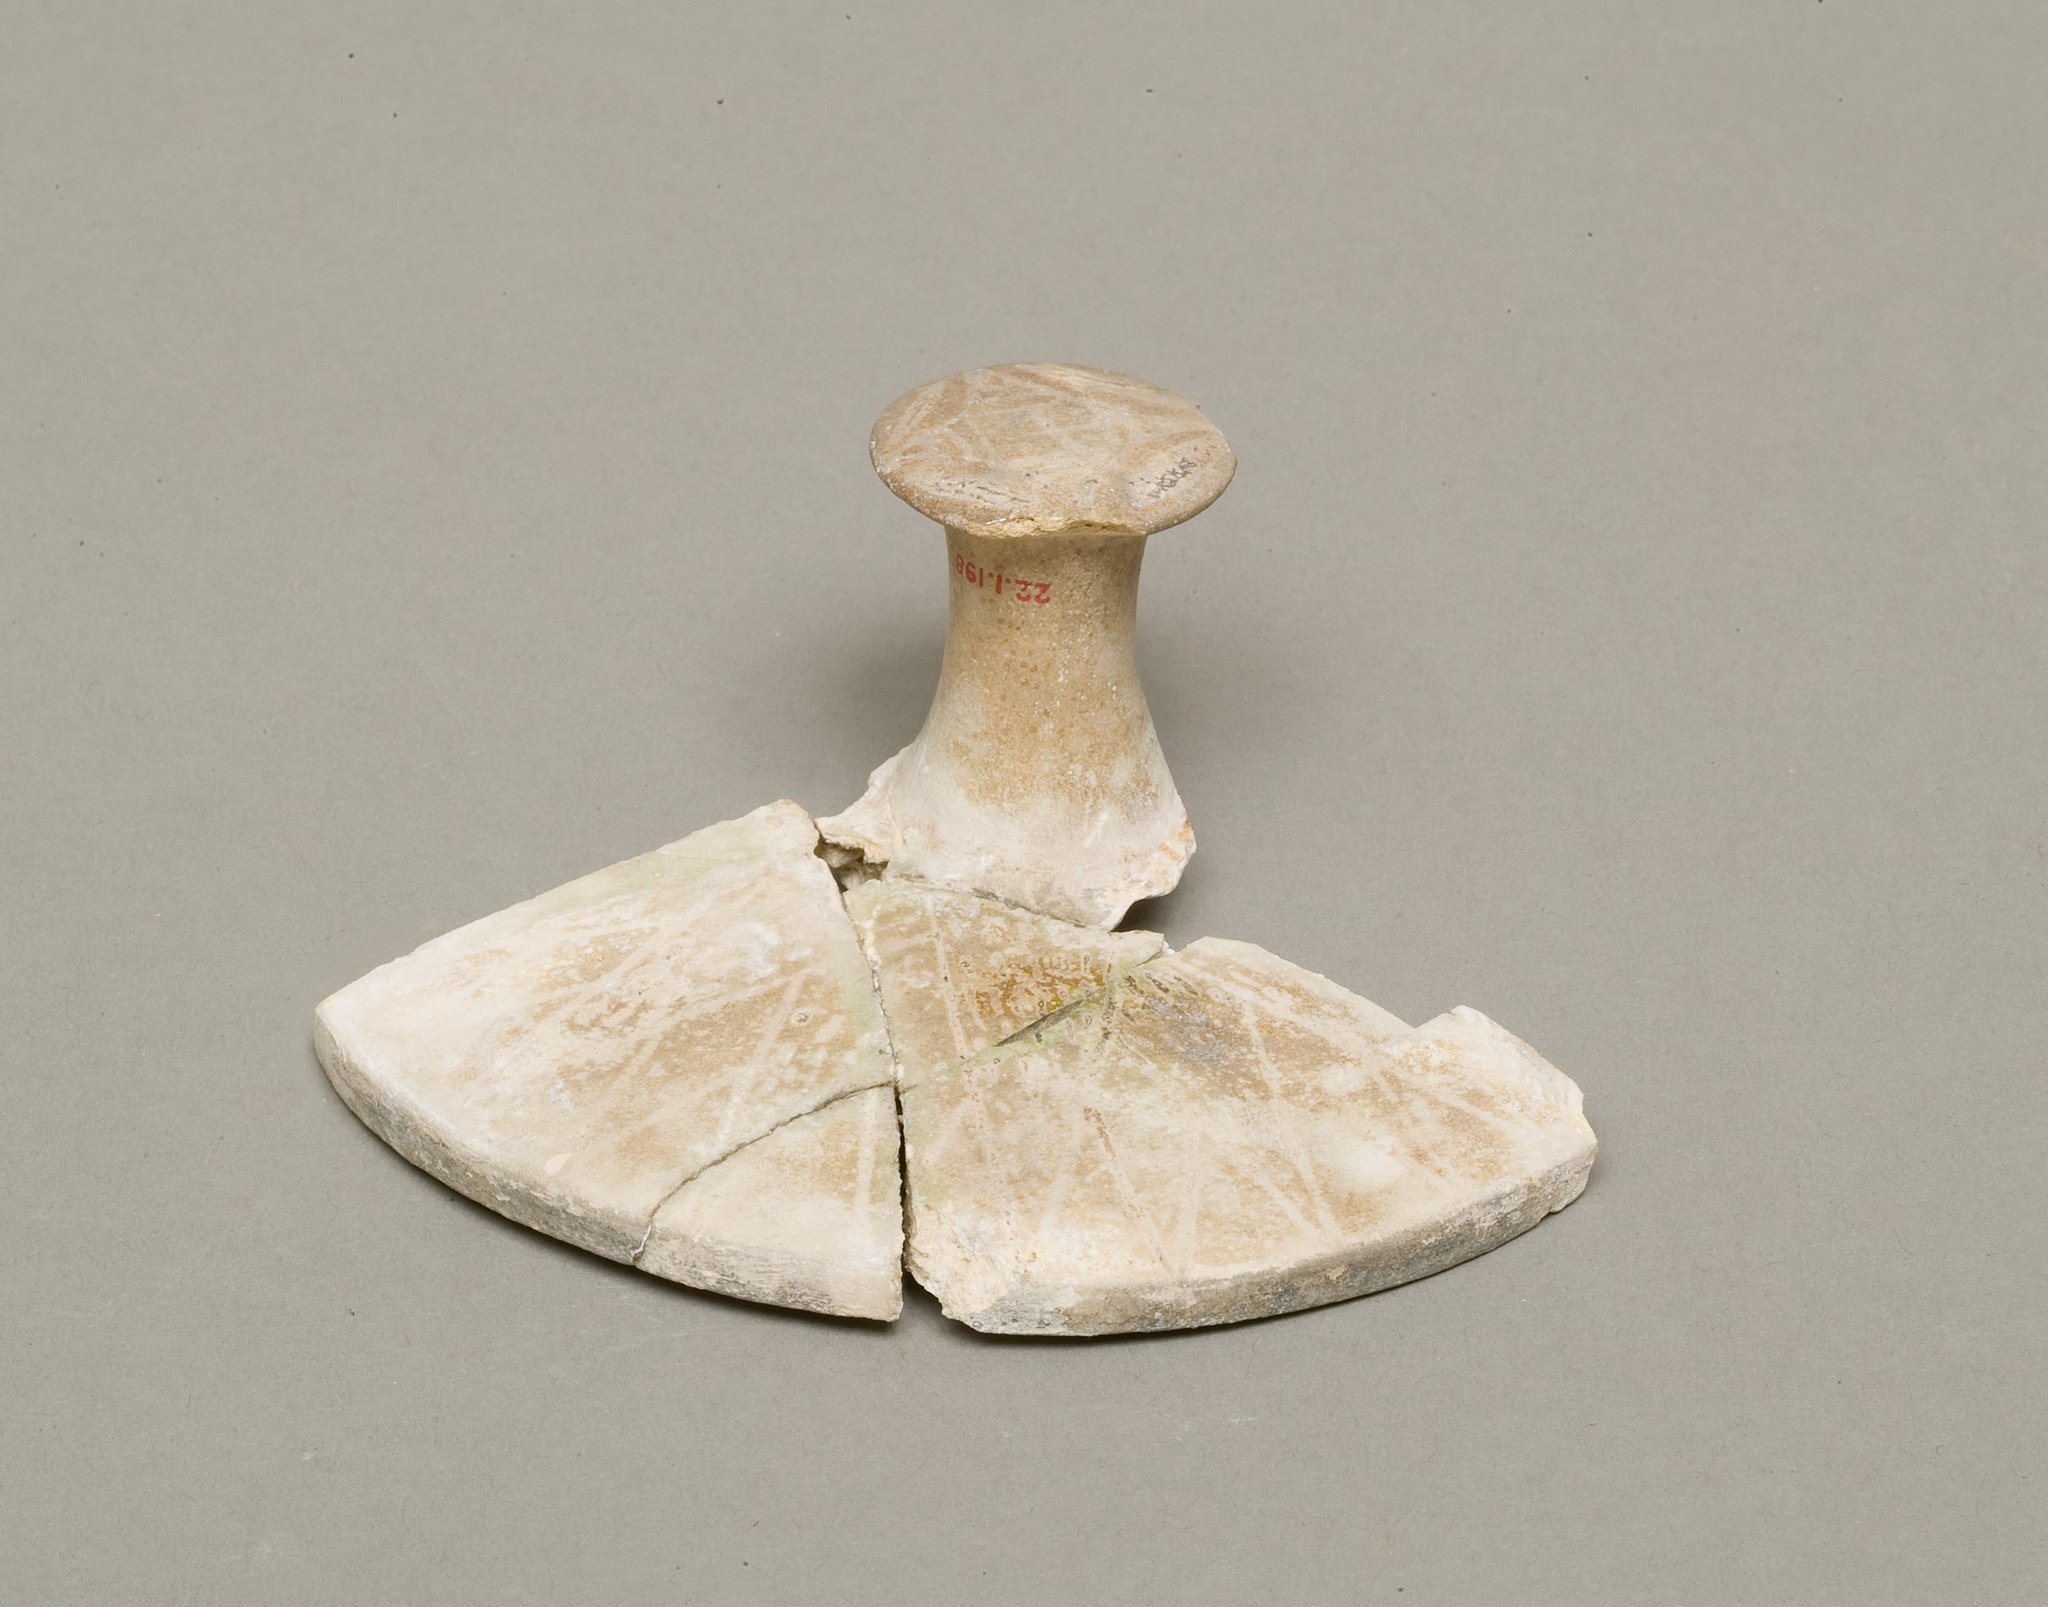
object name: model offering table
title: Model of an offering table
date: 1981-1640 BCE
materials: faience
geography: egypt